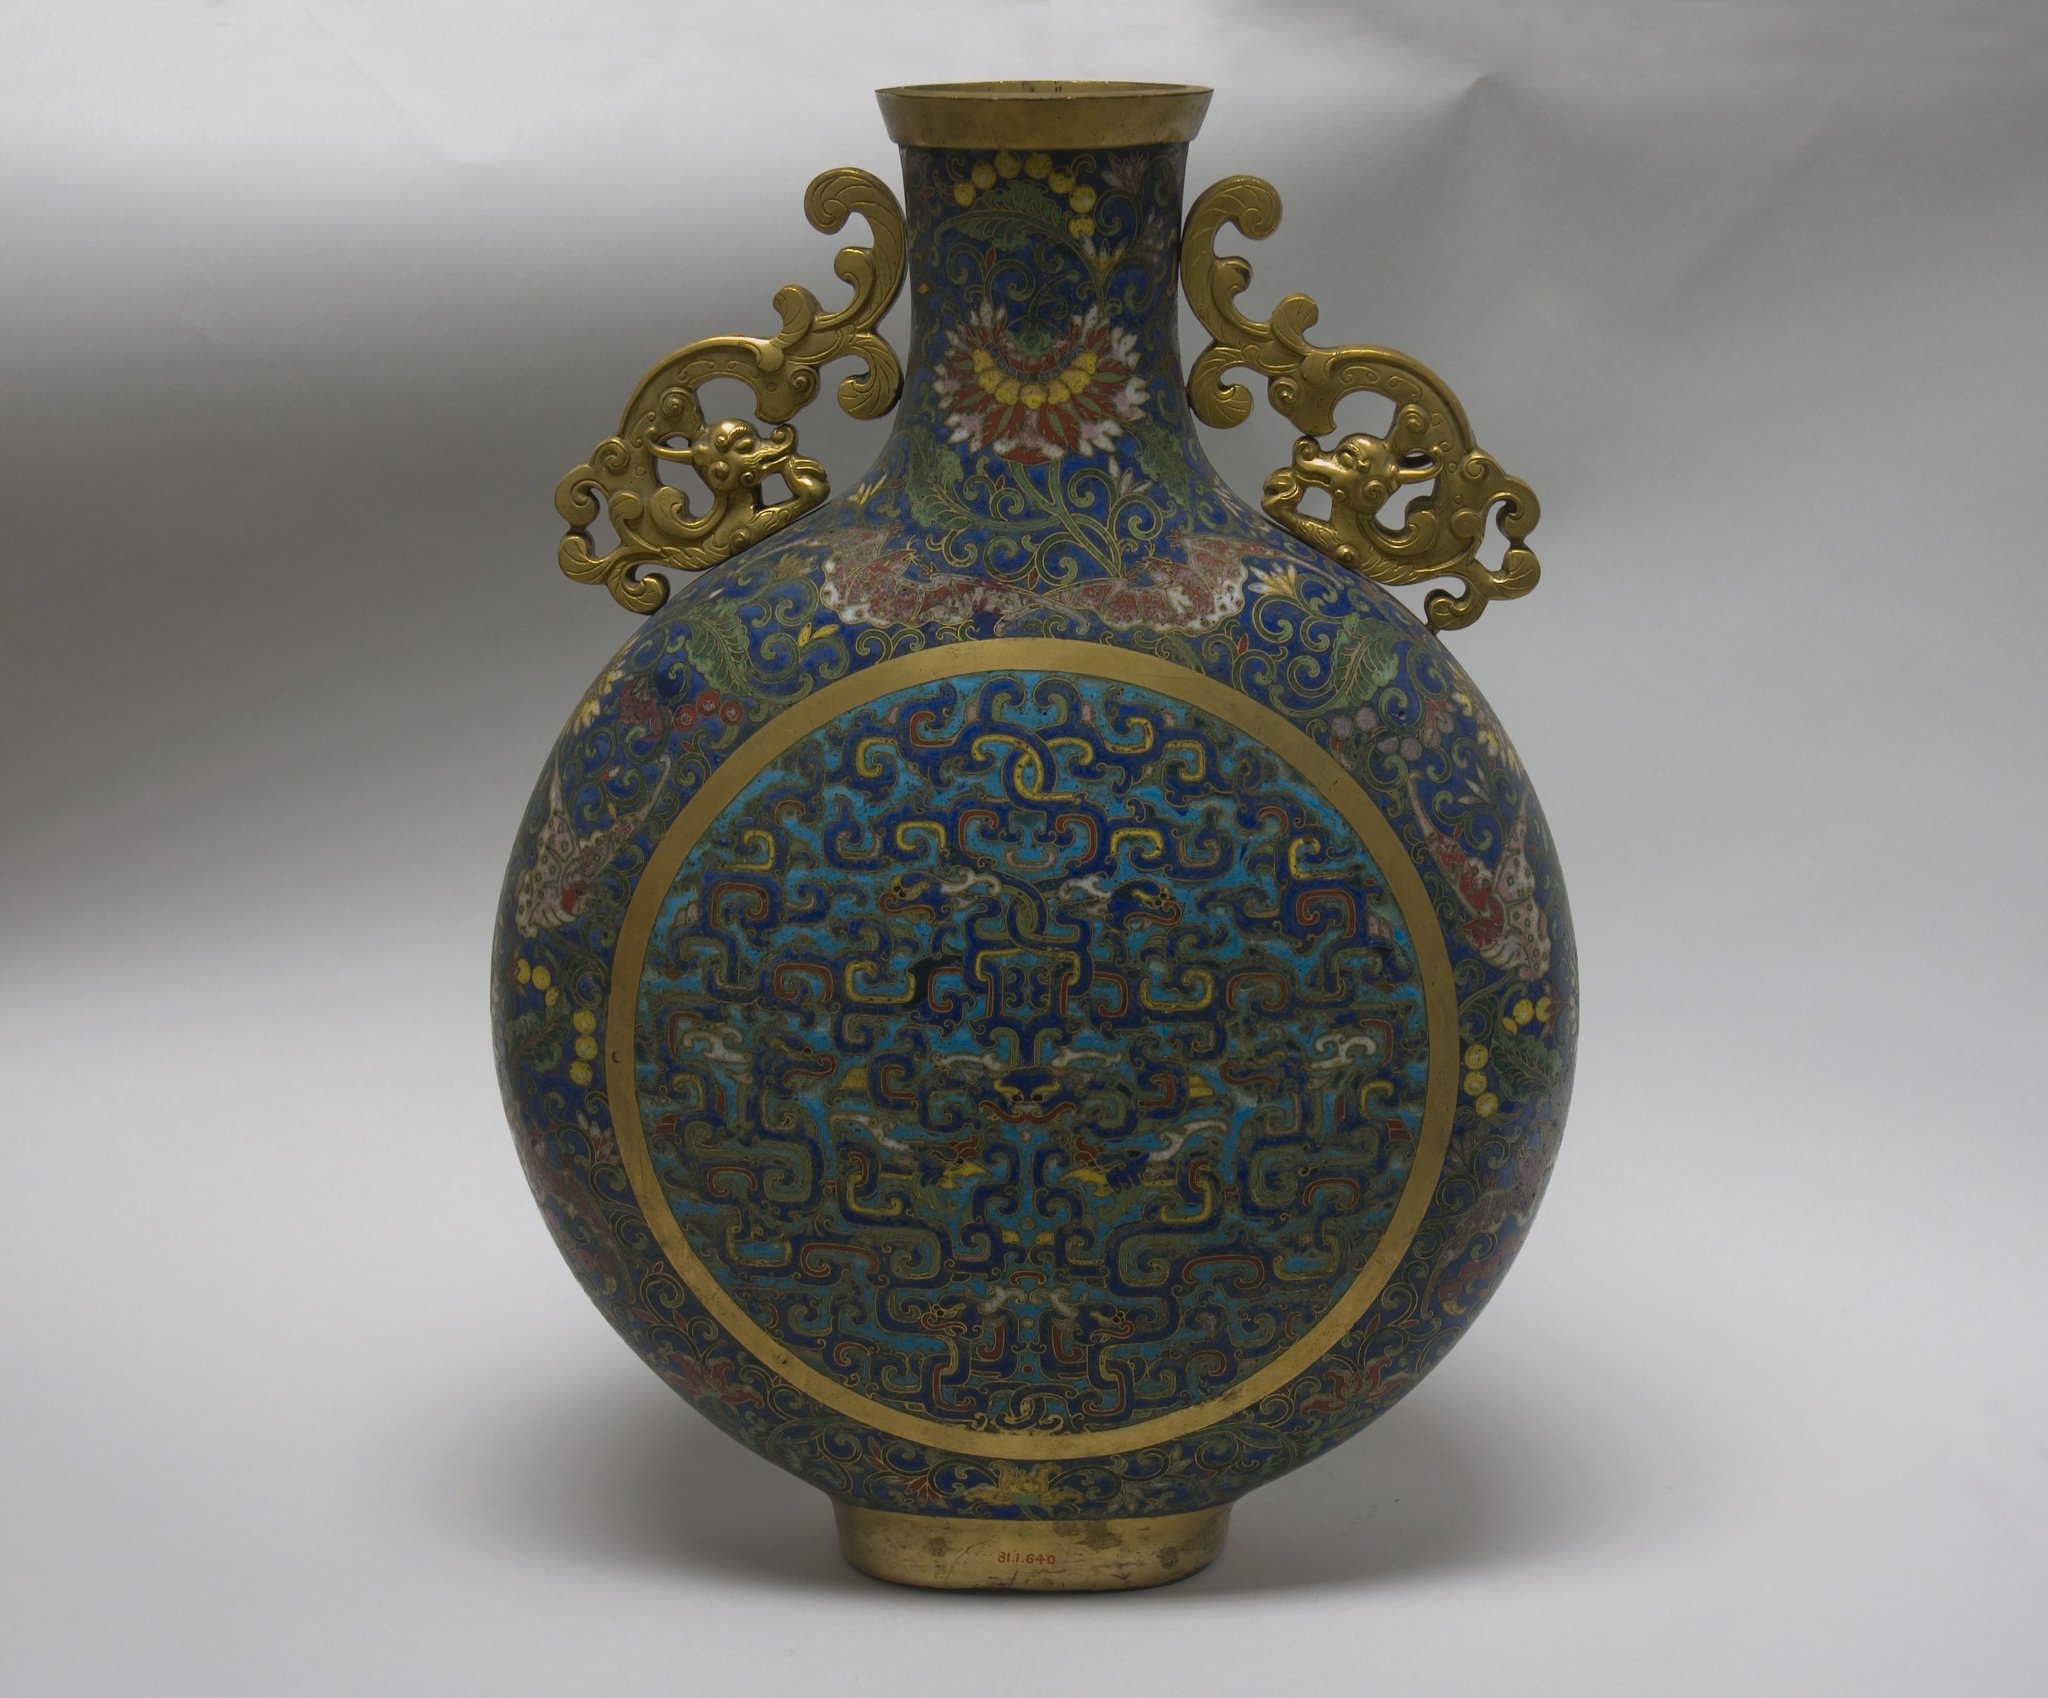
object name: vase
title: Flask vase with archaistic dragons and bats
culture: chinese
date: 1767-1833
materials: enamel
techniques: enamel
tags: flowers